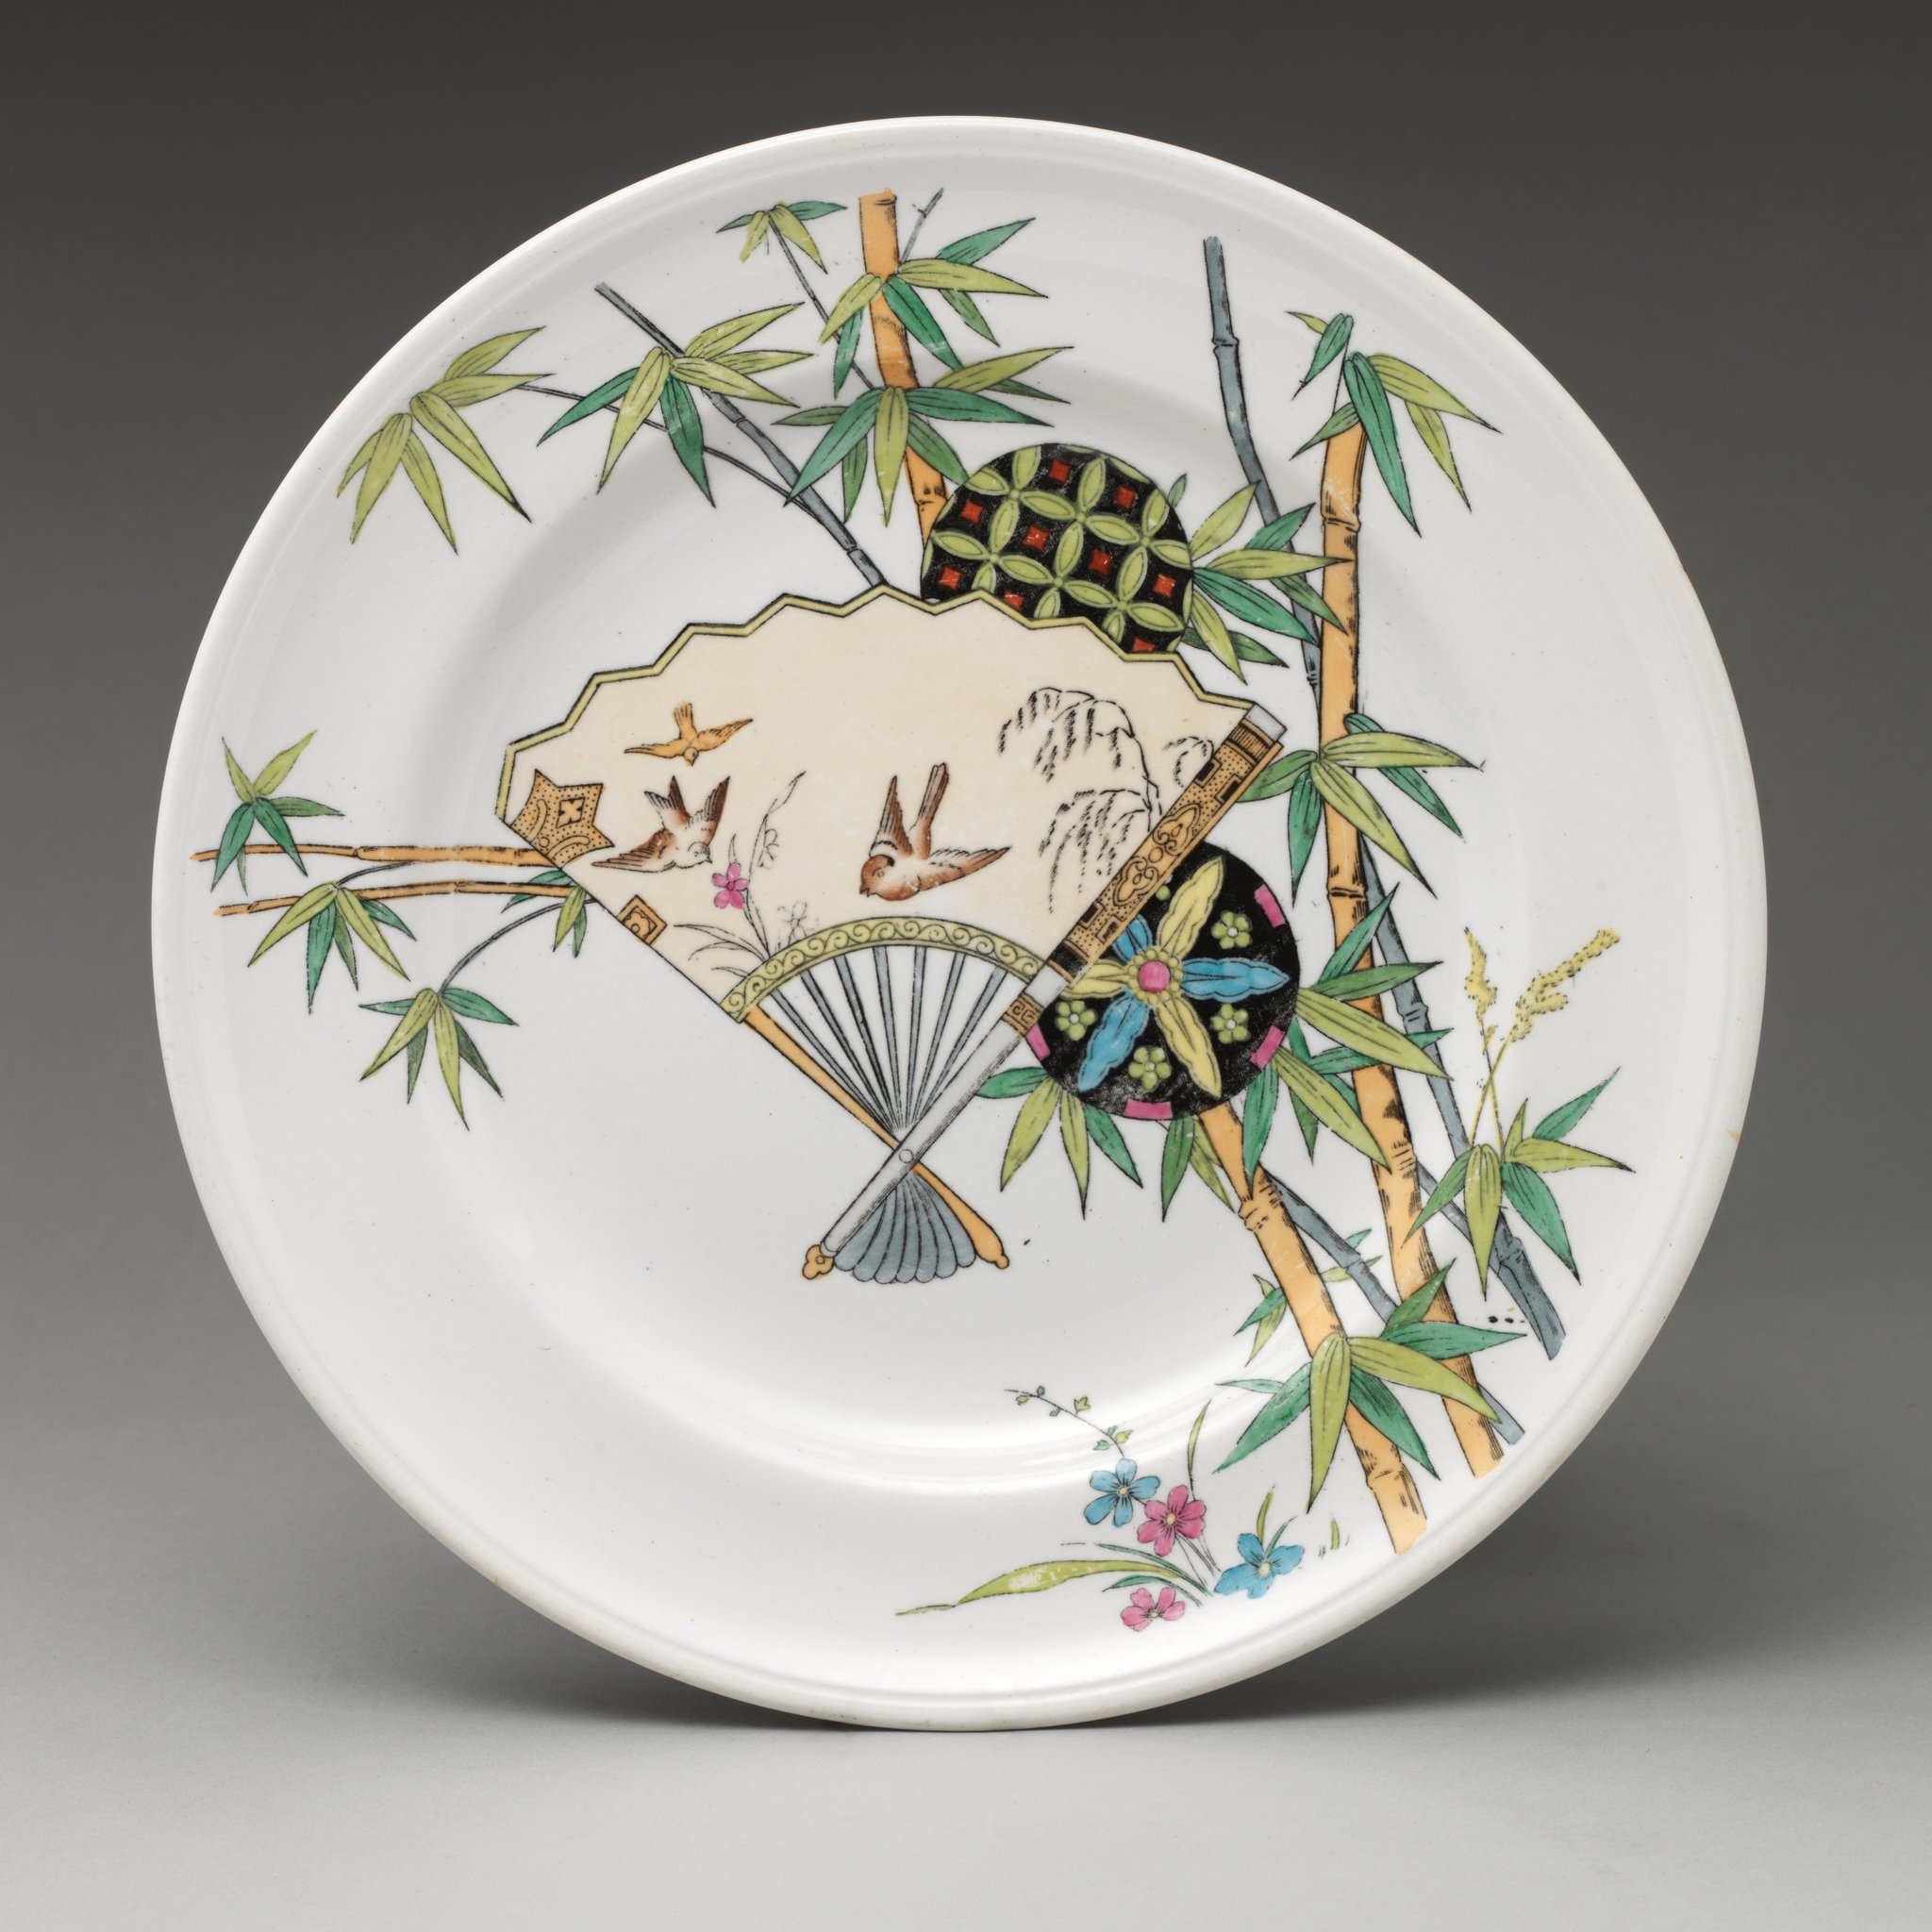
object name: plate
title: Plate with "Bamboo and Fan" pattern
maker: minton(s)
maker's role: factory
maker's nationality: british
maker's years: 1793-2001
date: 1877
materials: earthenware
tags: birds,fans,bamboo